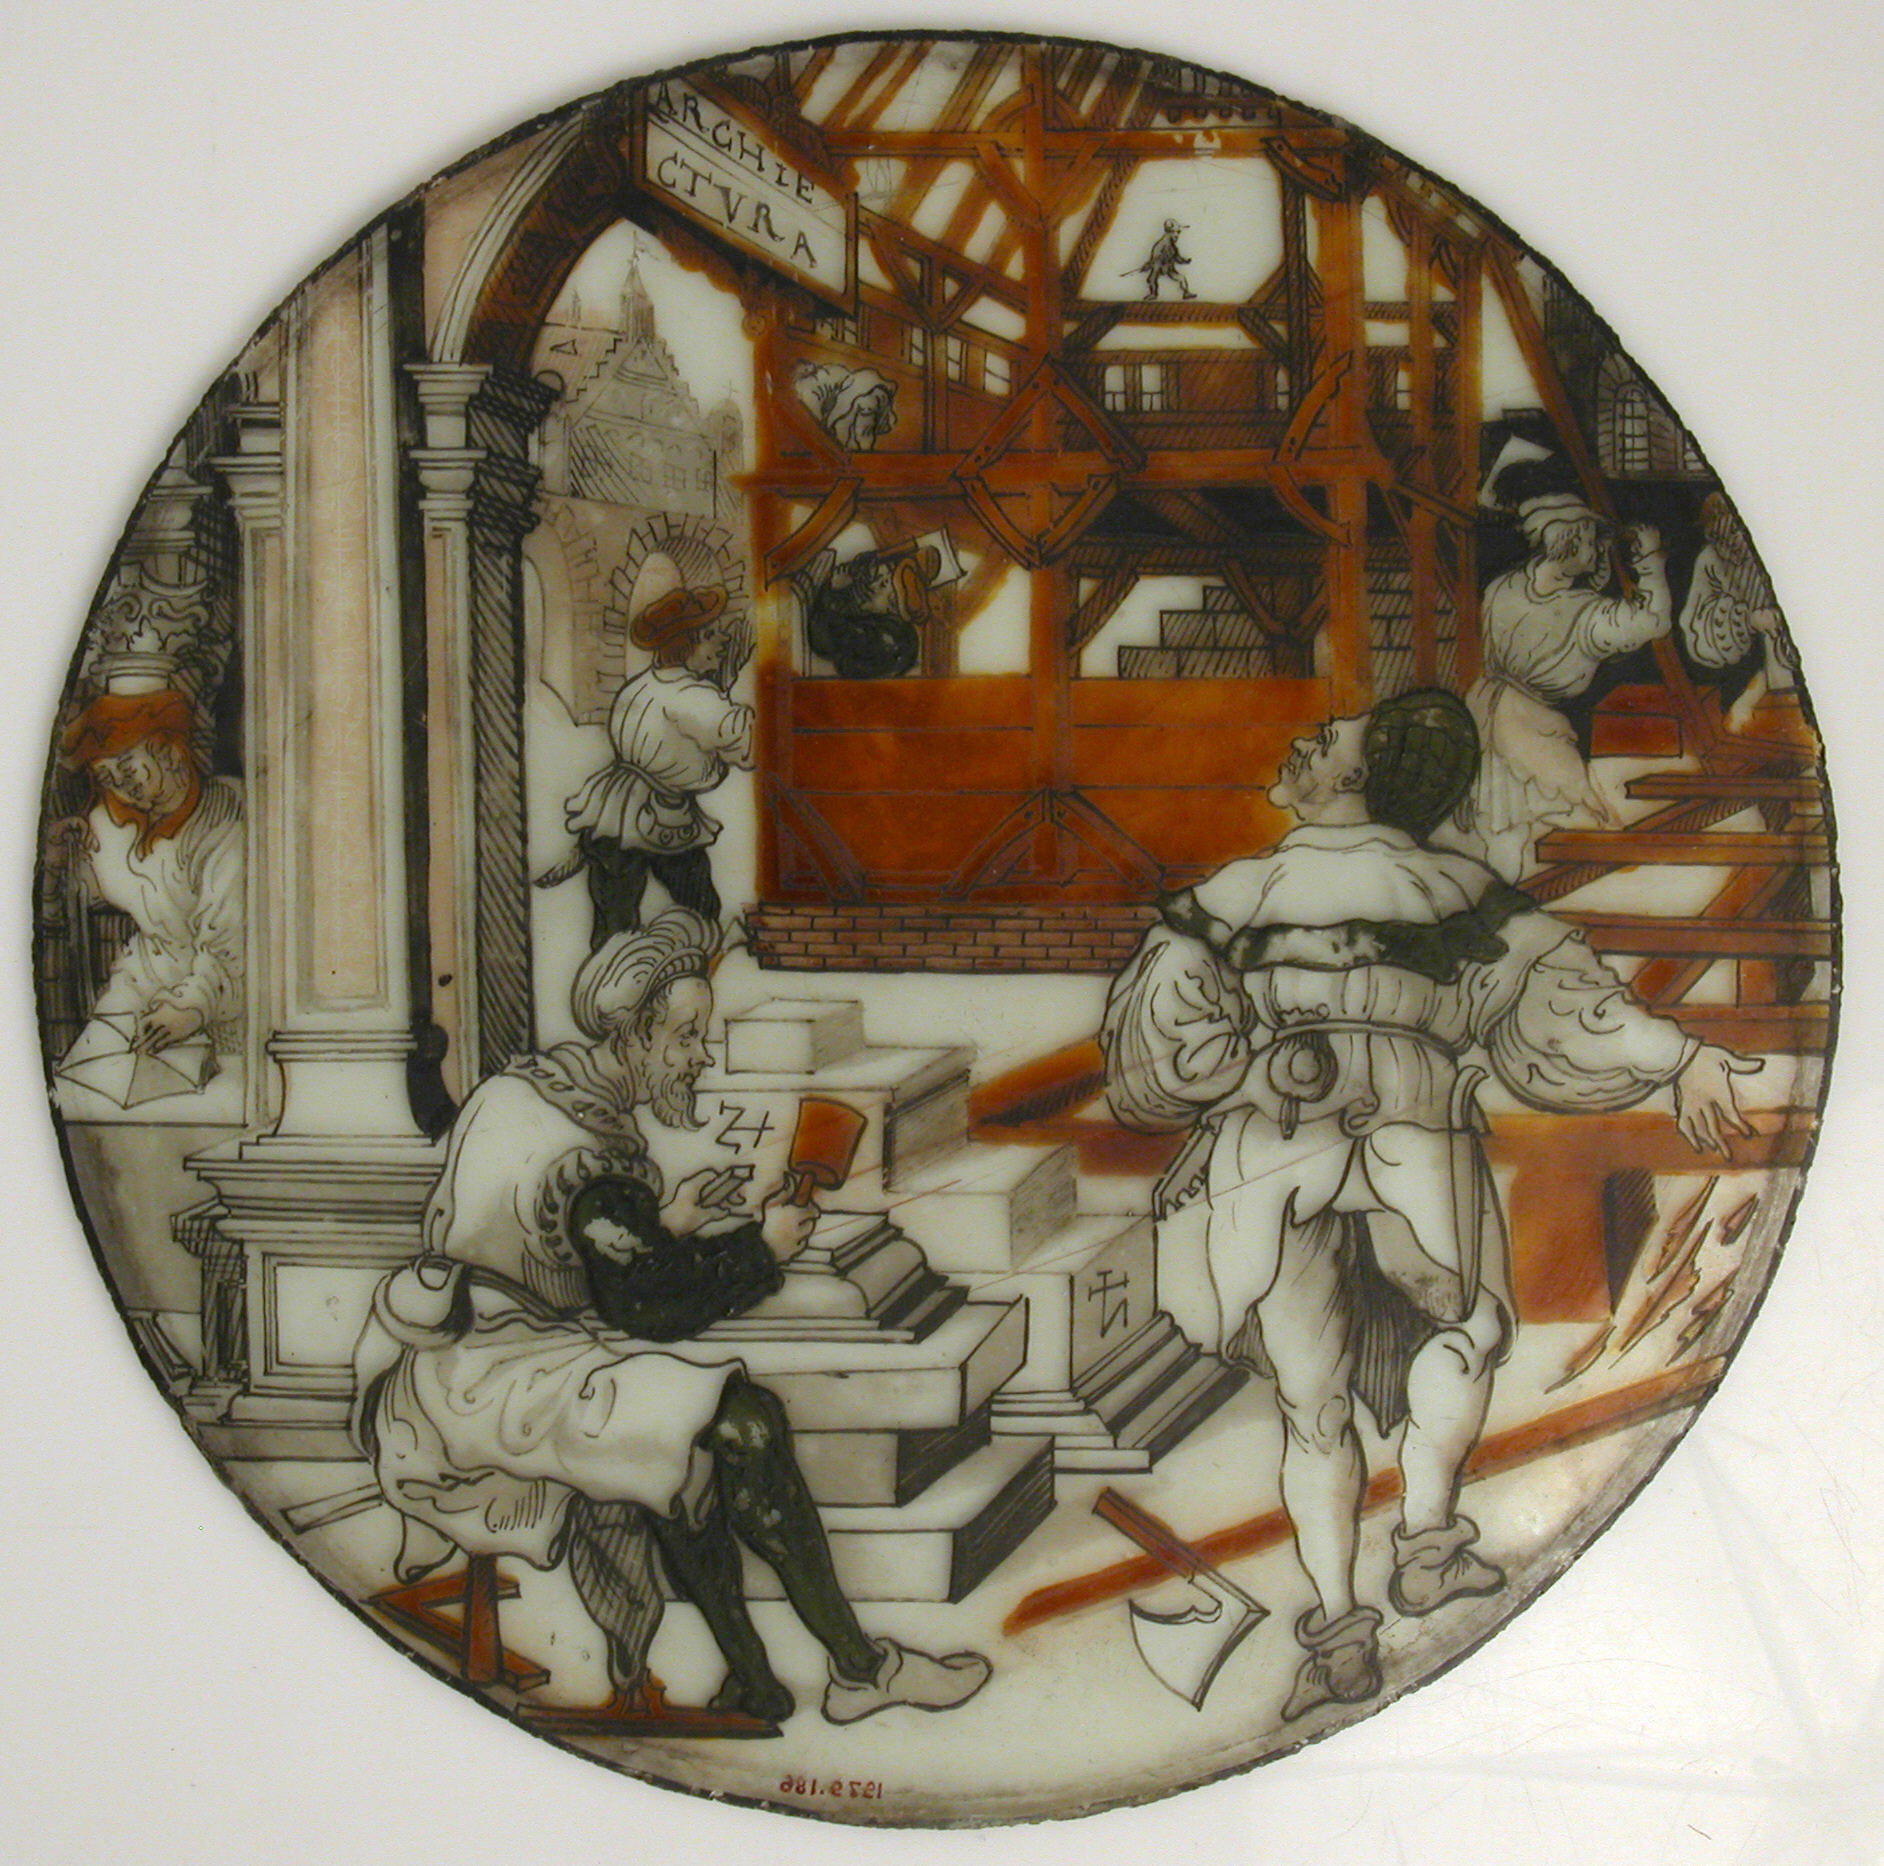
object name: roundel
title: Roundel with Architecture (from a series of The Septem Artes Mechanicae)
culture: german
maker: monogrammist sz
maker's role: artist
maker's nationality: german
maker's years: 1500-1600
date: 1563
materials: glass, paint, pigment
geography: germany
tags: buildings,men,working